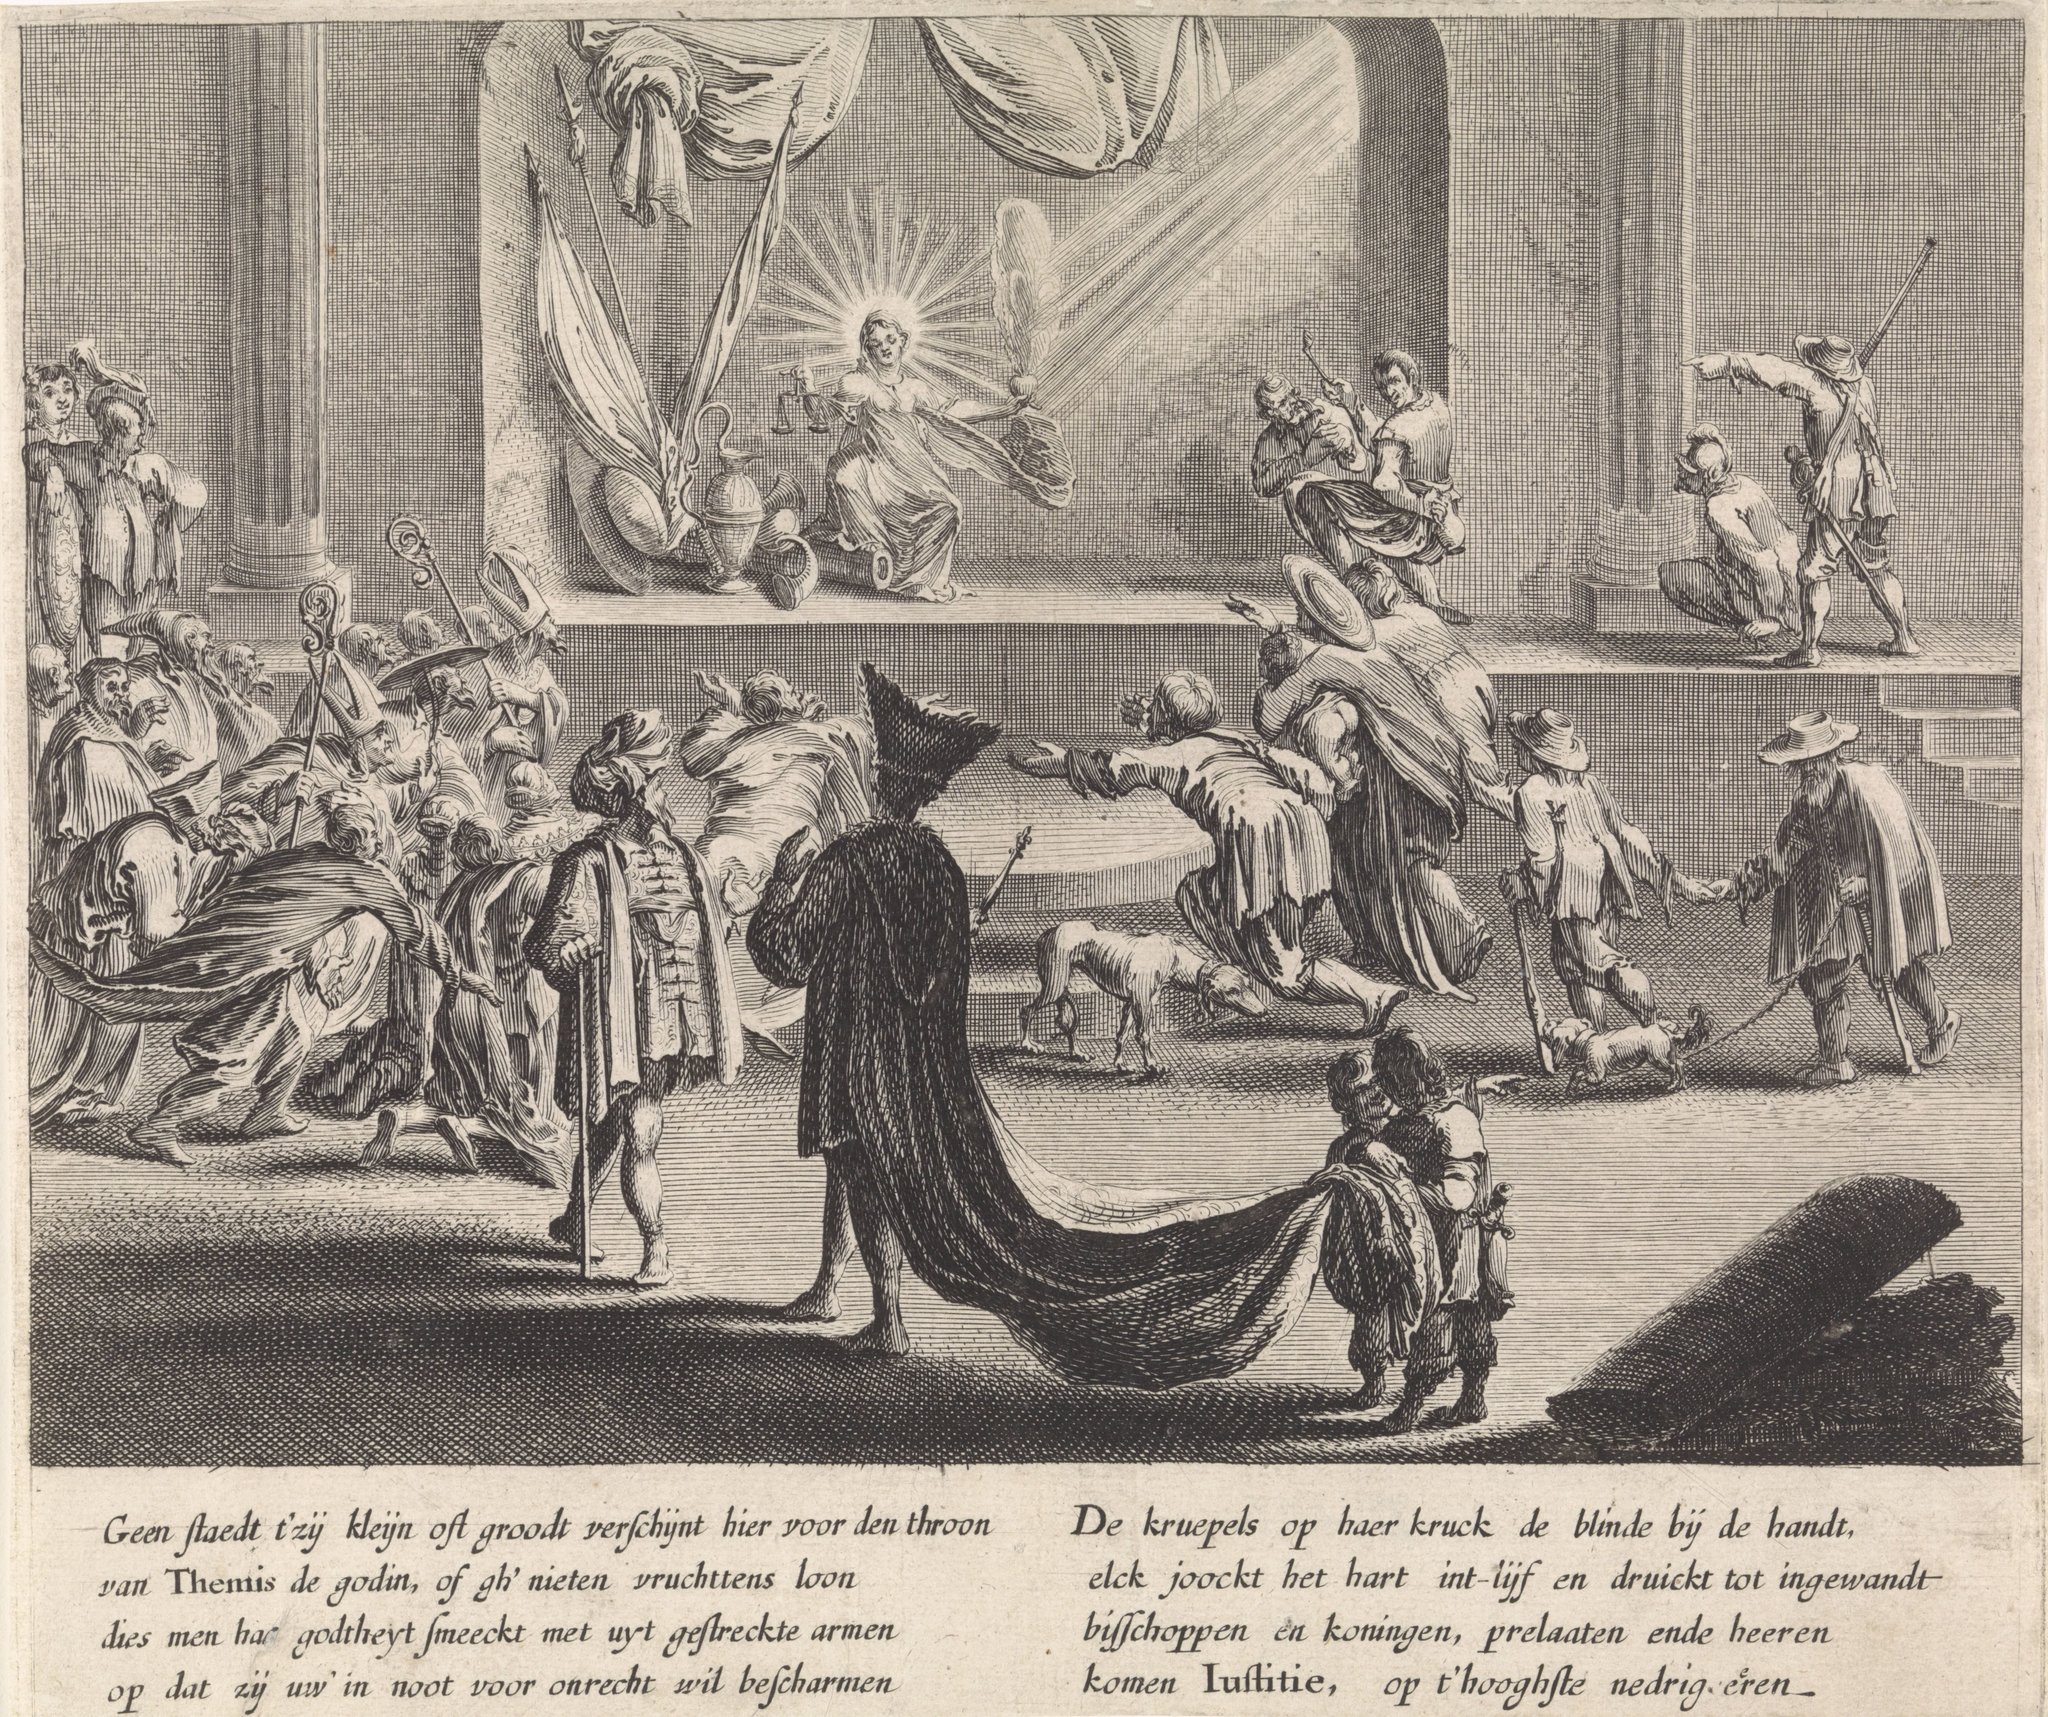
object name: print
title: Eerbetoon aan Justitia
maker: pieter nolpe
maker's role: draughtsman, print maker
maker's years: 1613-1653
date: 1623-1653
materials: paper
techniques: engraving, etching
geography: amsterdam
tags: justice, 'justitia'; 'giustitia divina' (ripa) ~ one of the four cardinal virtues, themis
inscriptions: collector's mark: Lugt 2228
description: Op een podium zit de godin Themis als vrouwe Justitia met in een hand de weegschaal en in de andere hand een brandend hart. Rijken, armen, koningen en bisschoppen, iedereen komt voor haar troon. Onder de voorstelling staan twee vierregelige verzen in het Nederlands.